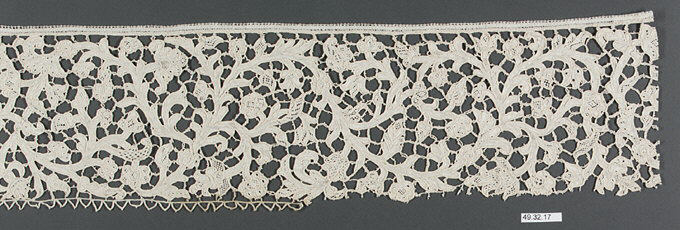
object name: border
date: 1667-1733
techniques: lace